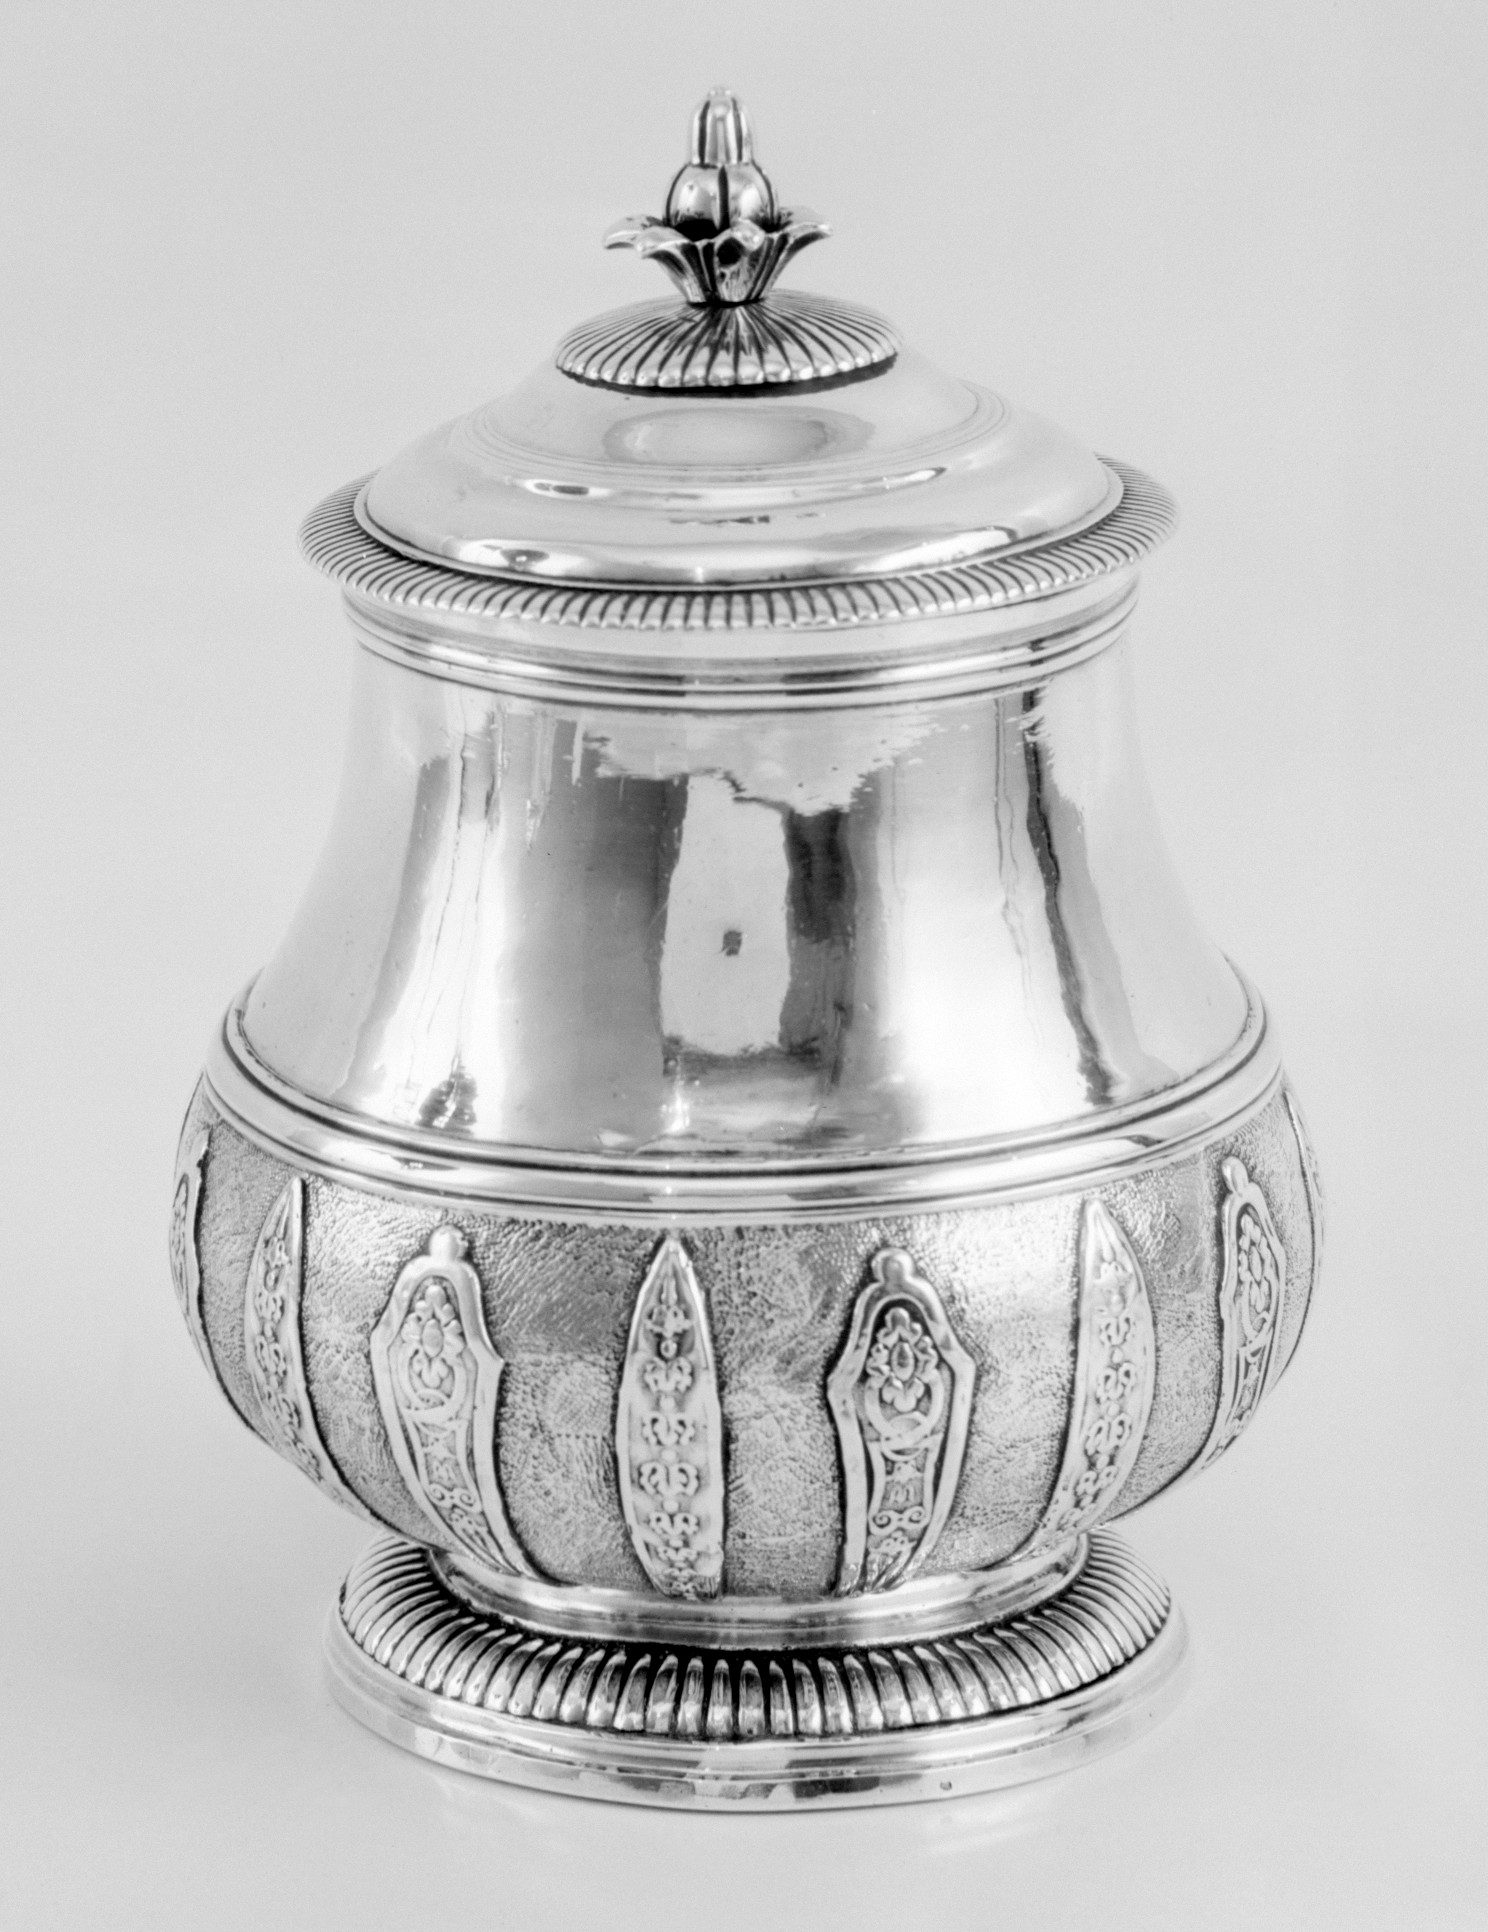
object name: sugar bowl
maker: p.s.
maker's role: maker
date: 1740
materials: silver